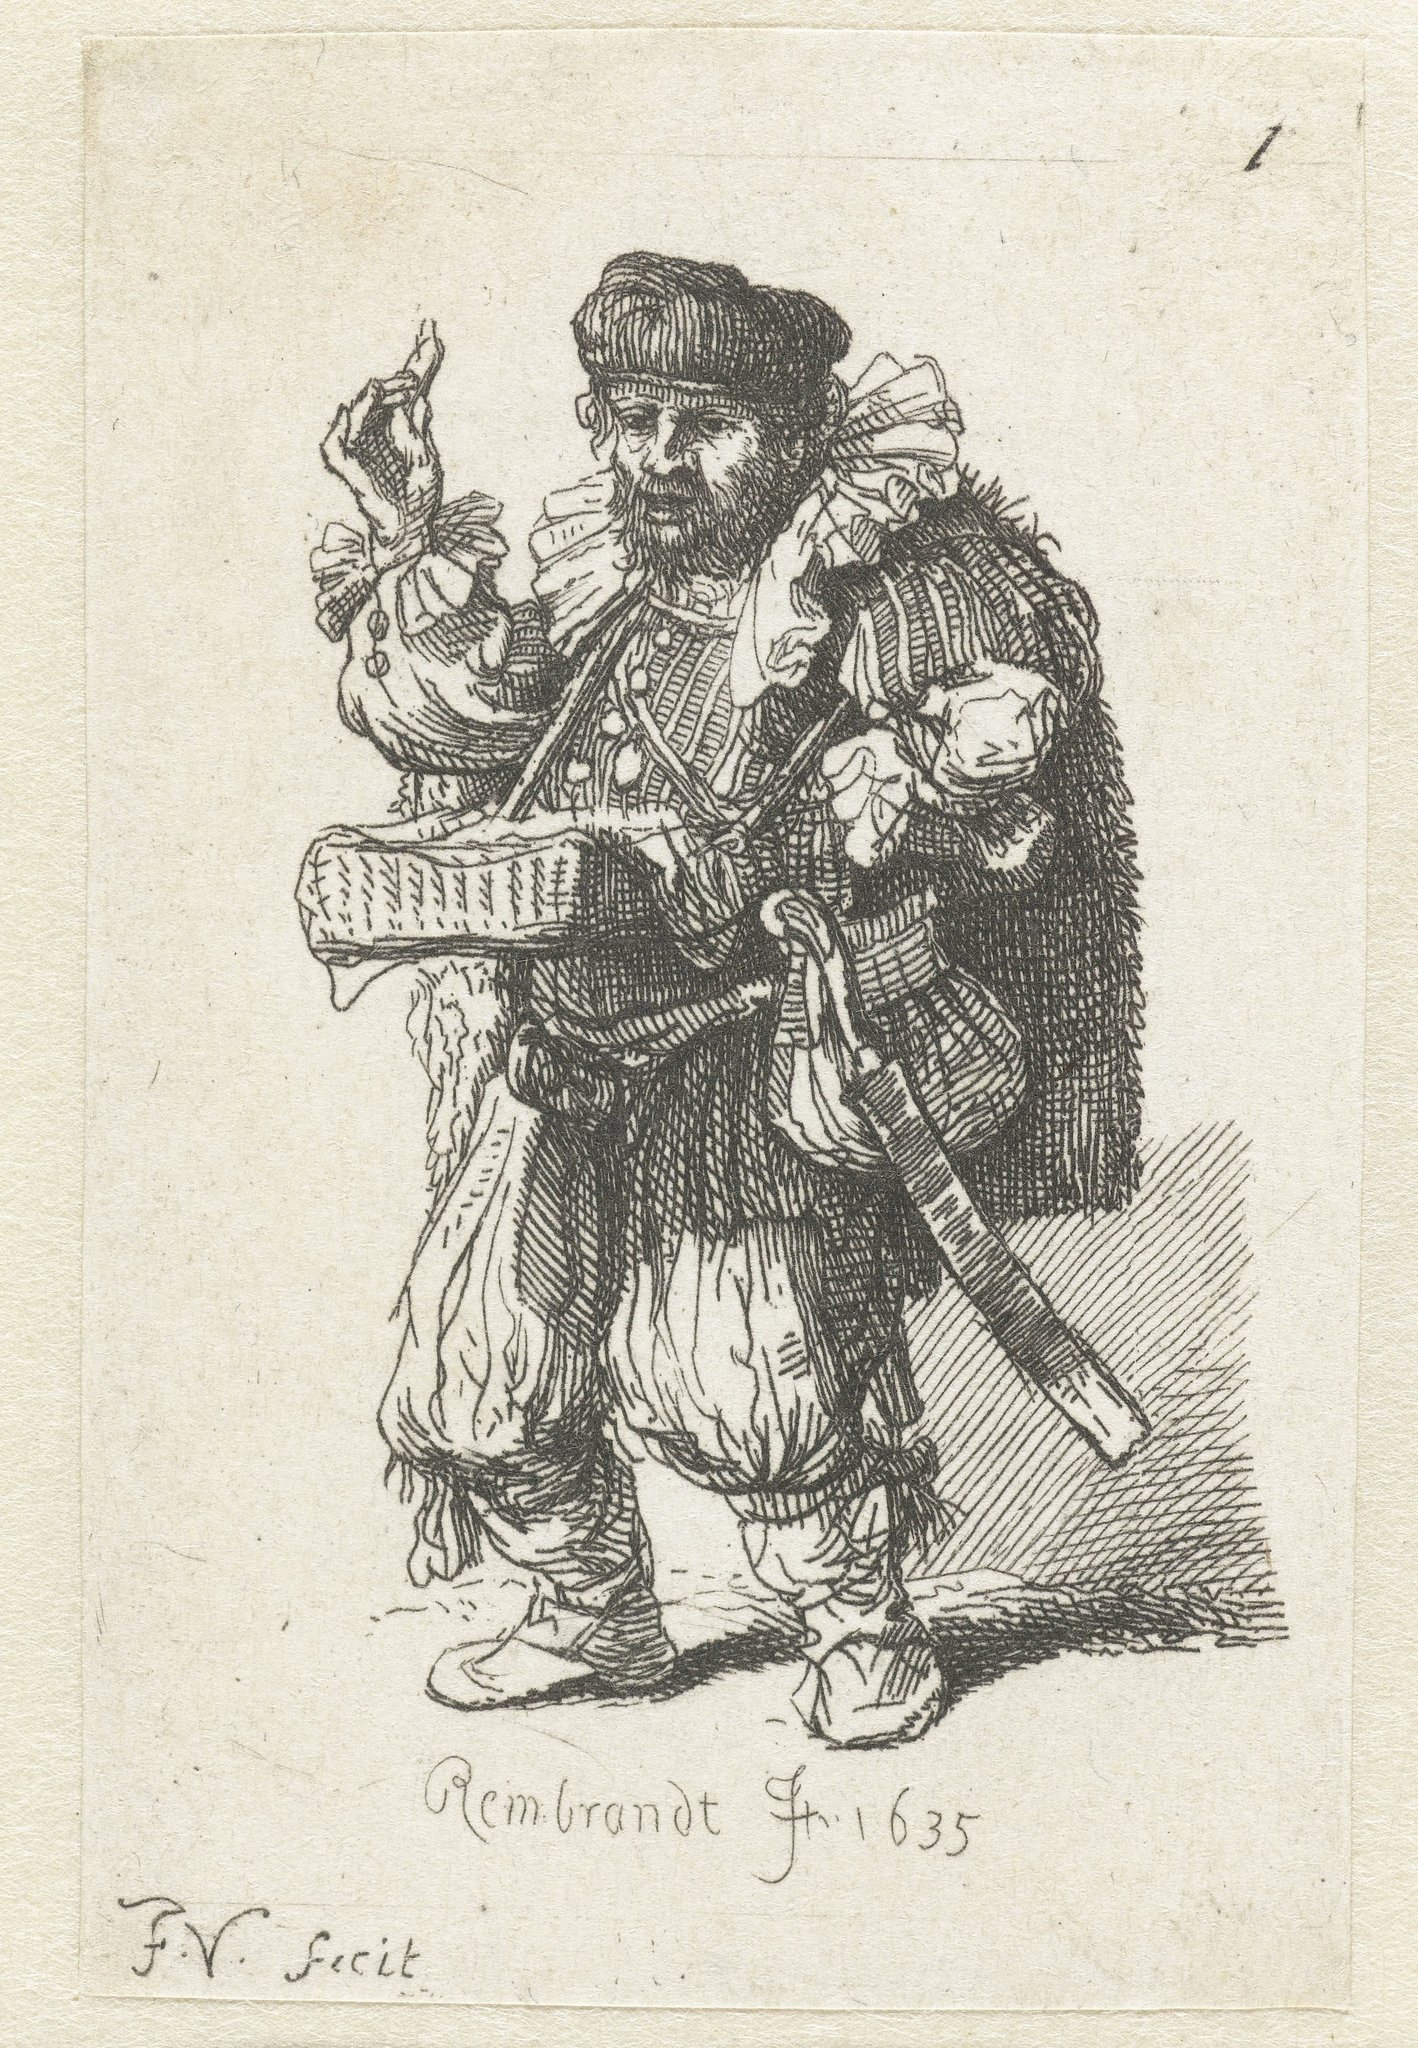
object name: print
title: The quacksalver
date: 1719-1780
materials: paper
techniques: etching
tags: quack, charlatan, mountebank, 'saltimbanco'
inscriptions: collector's mark: Lugt 2228, collector's mark: Lugt 2760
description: Spiegelbeeldige kopie naar de gelijknamige prent van Rembrandt.